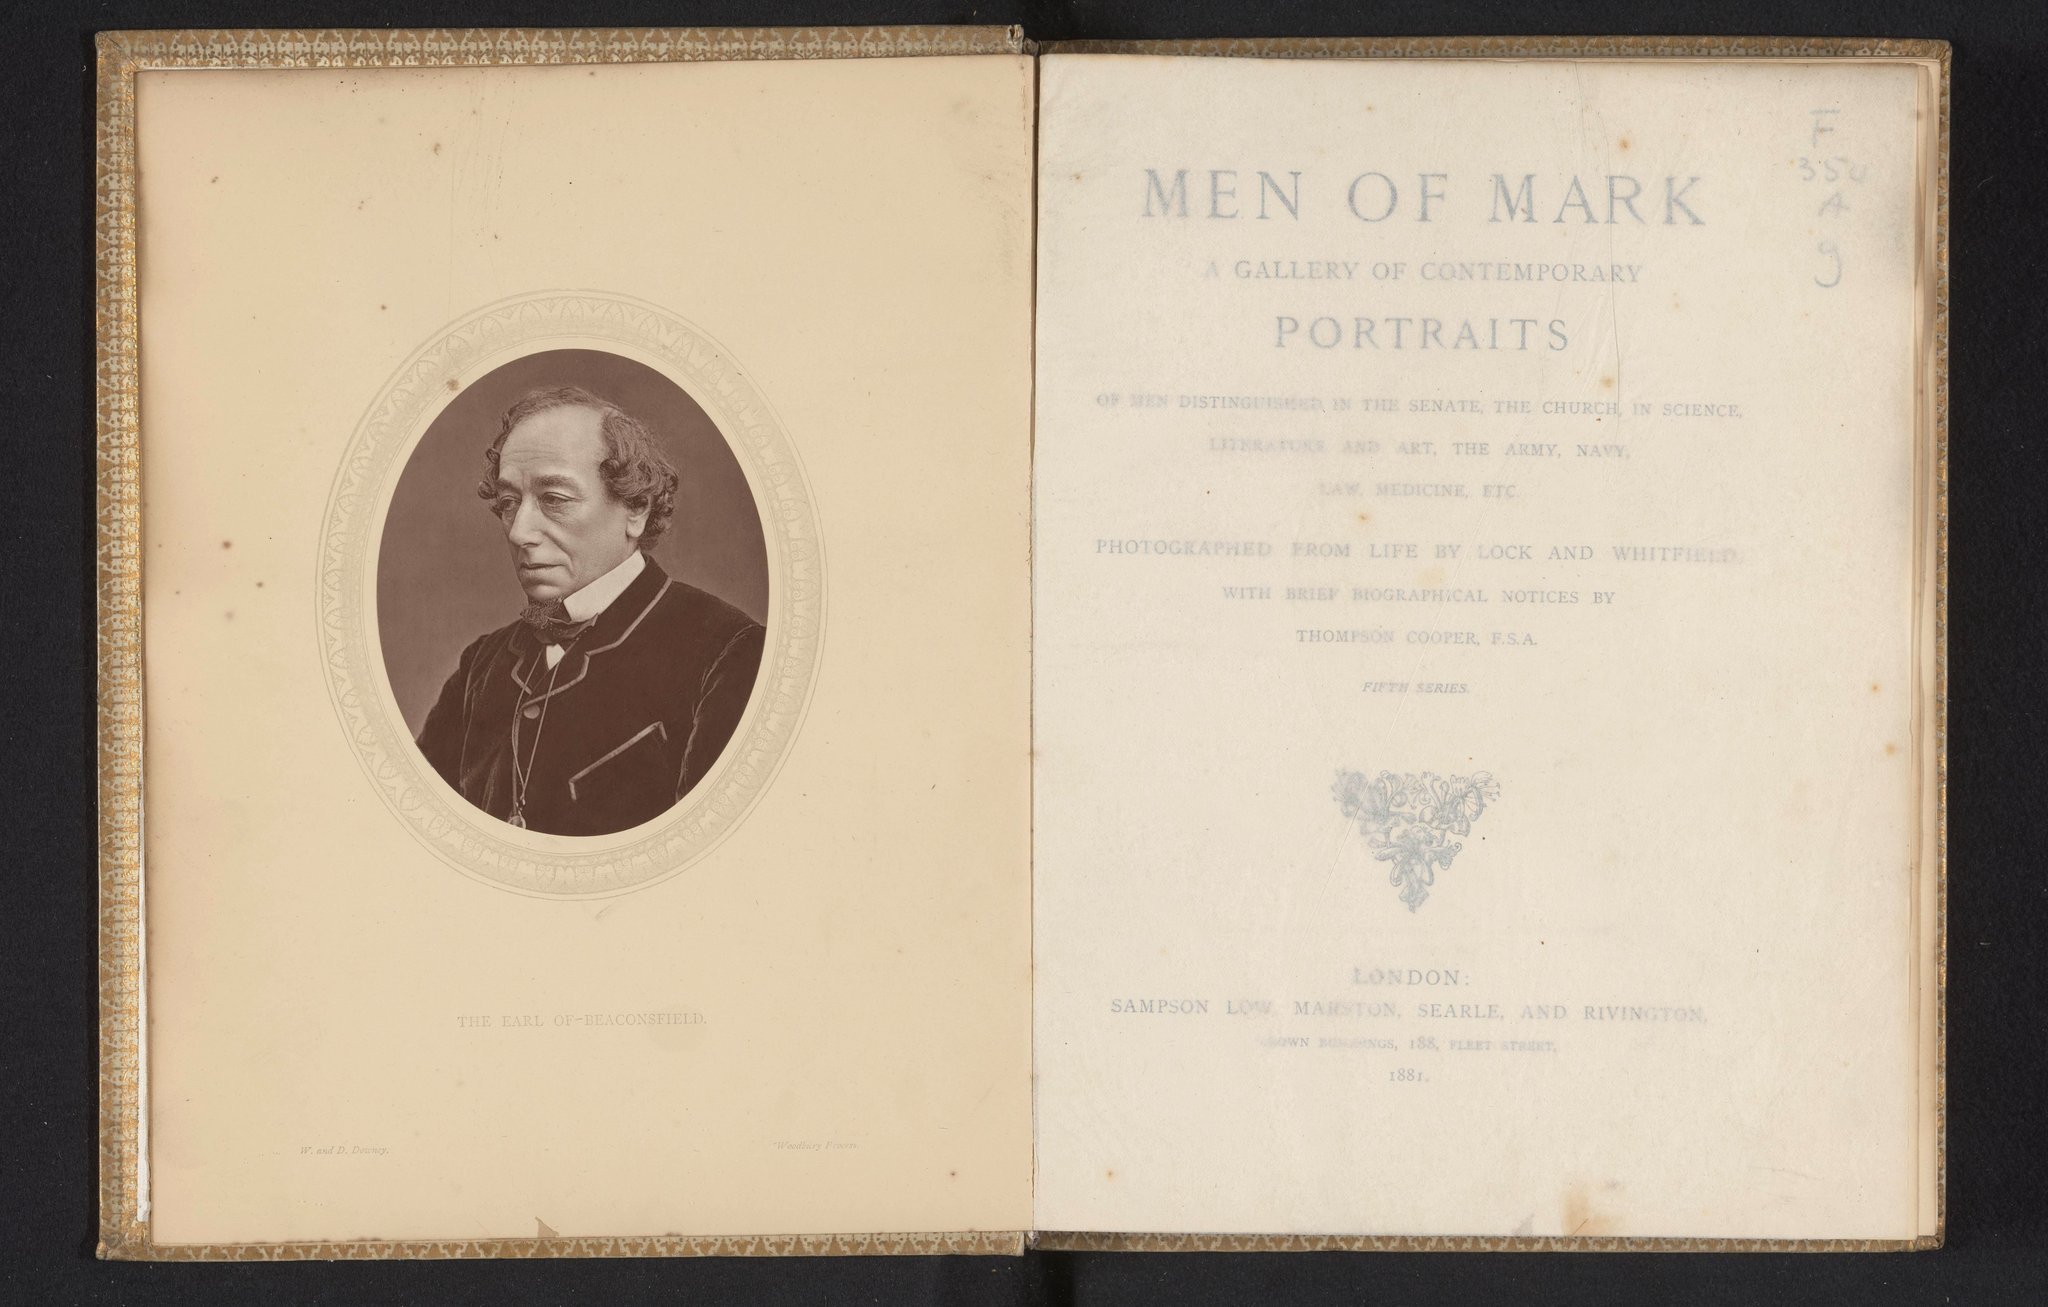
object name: page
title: The earl of Beaconsfield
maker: Anonymous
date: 1876-1881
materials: paper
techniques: woodburytype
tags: historical persons (portraits and scenes from the life) (+ (full) bust portrait), politician, e.g. party leader